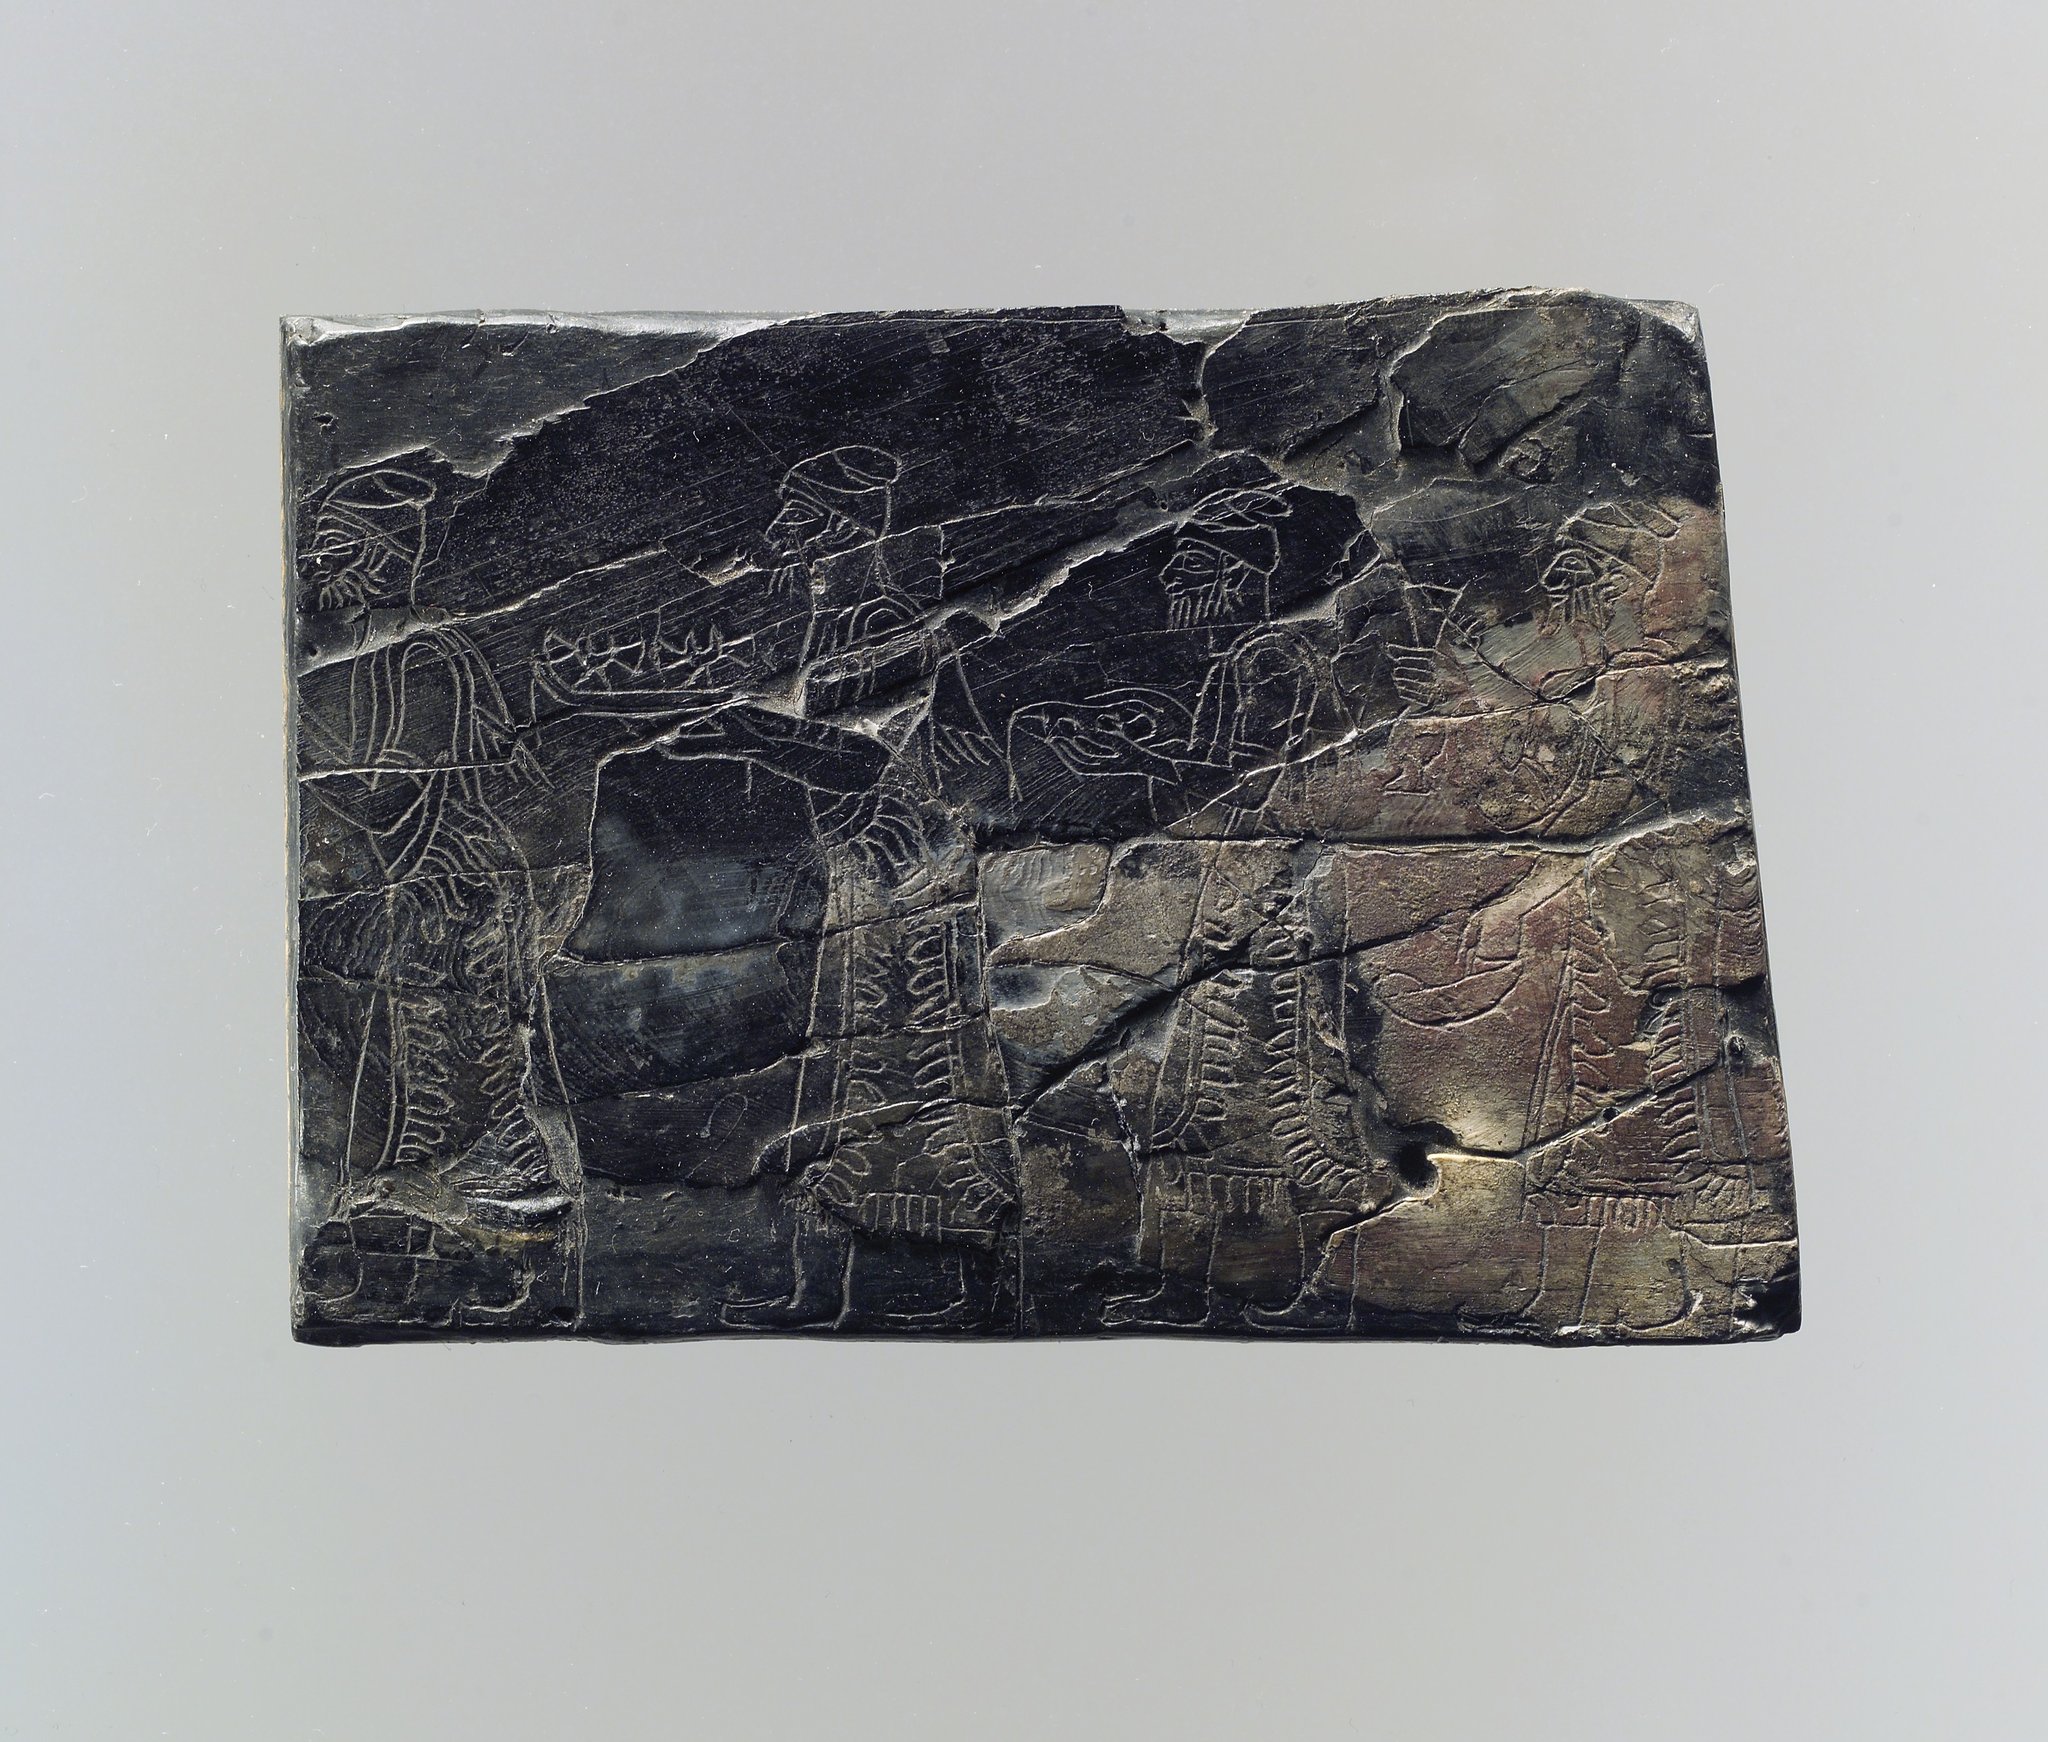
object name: relief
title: Plaque with tribute bearers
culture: assyrian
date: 900-701 BCE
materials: ivory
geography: mesopotamia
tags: men